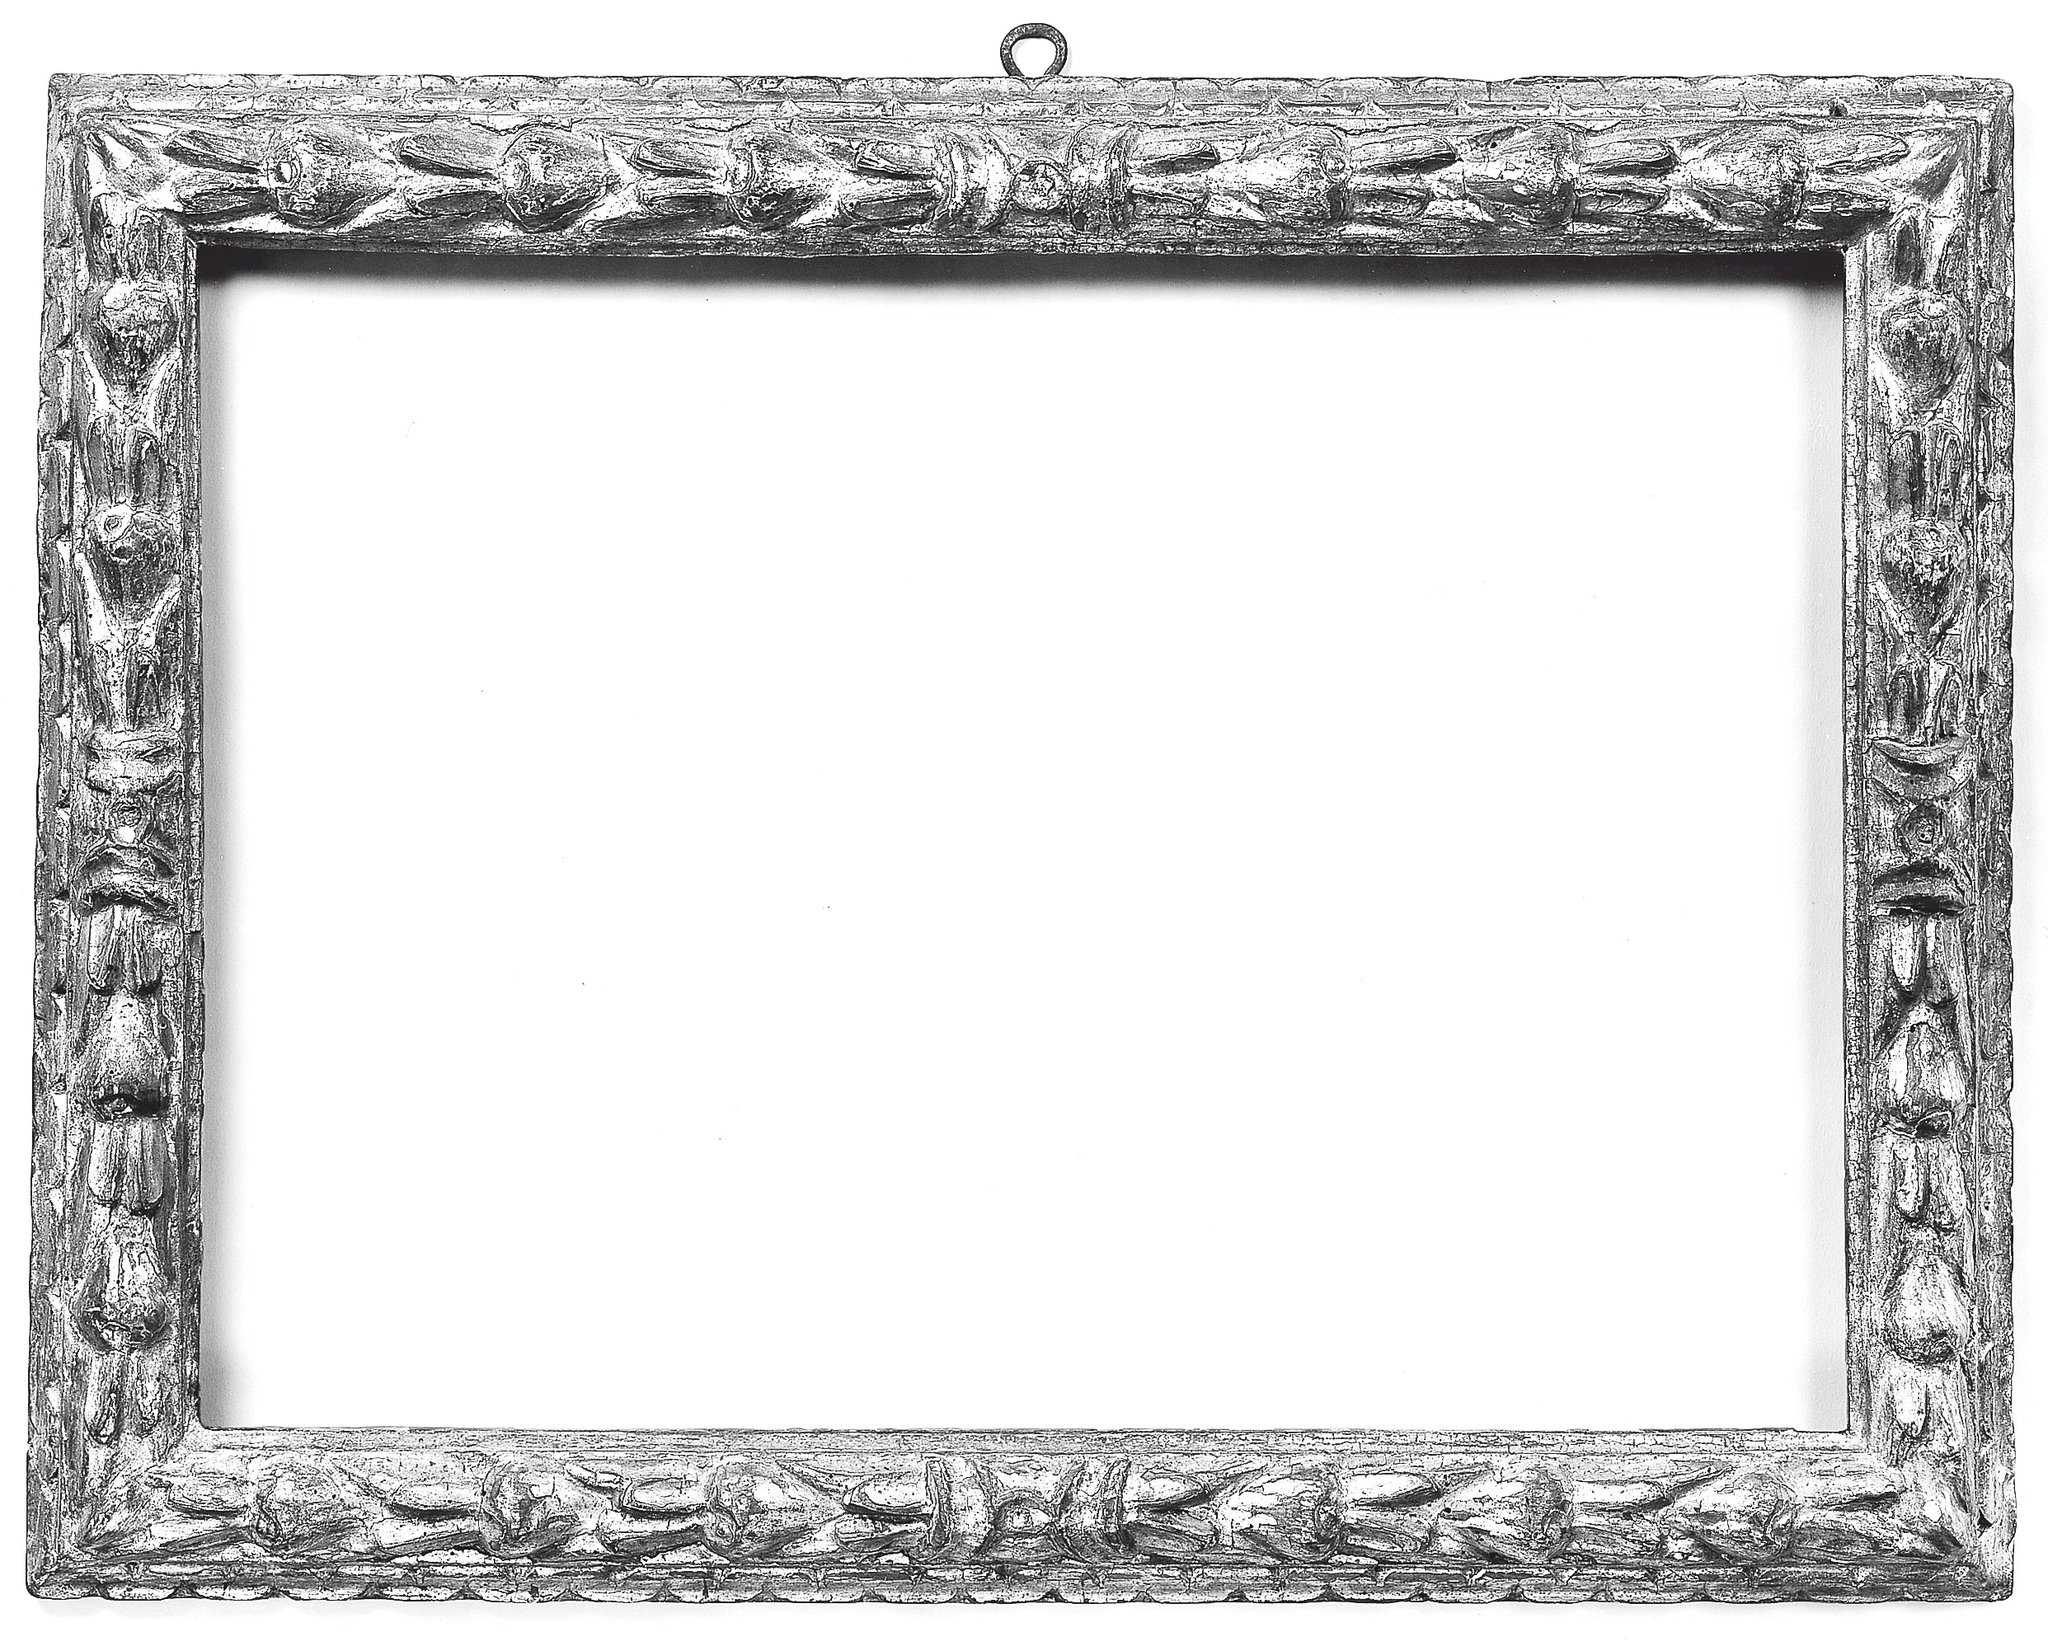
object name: frame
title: Astragal frame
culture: italian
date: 1601-1633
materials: wood